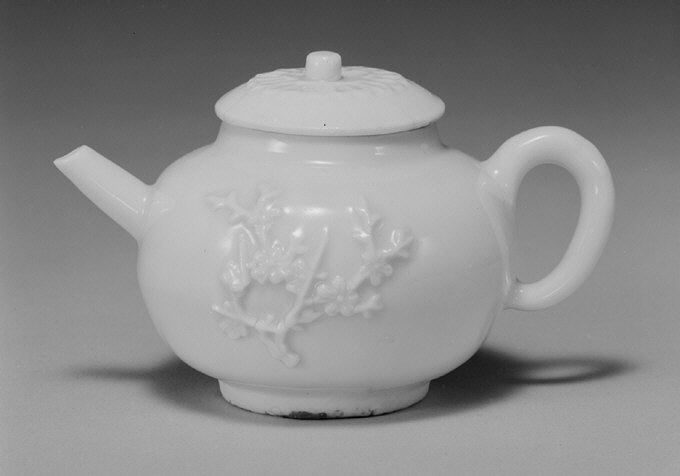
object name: teapot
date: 1760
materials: hard paste porcelain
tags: flowers